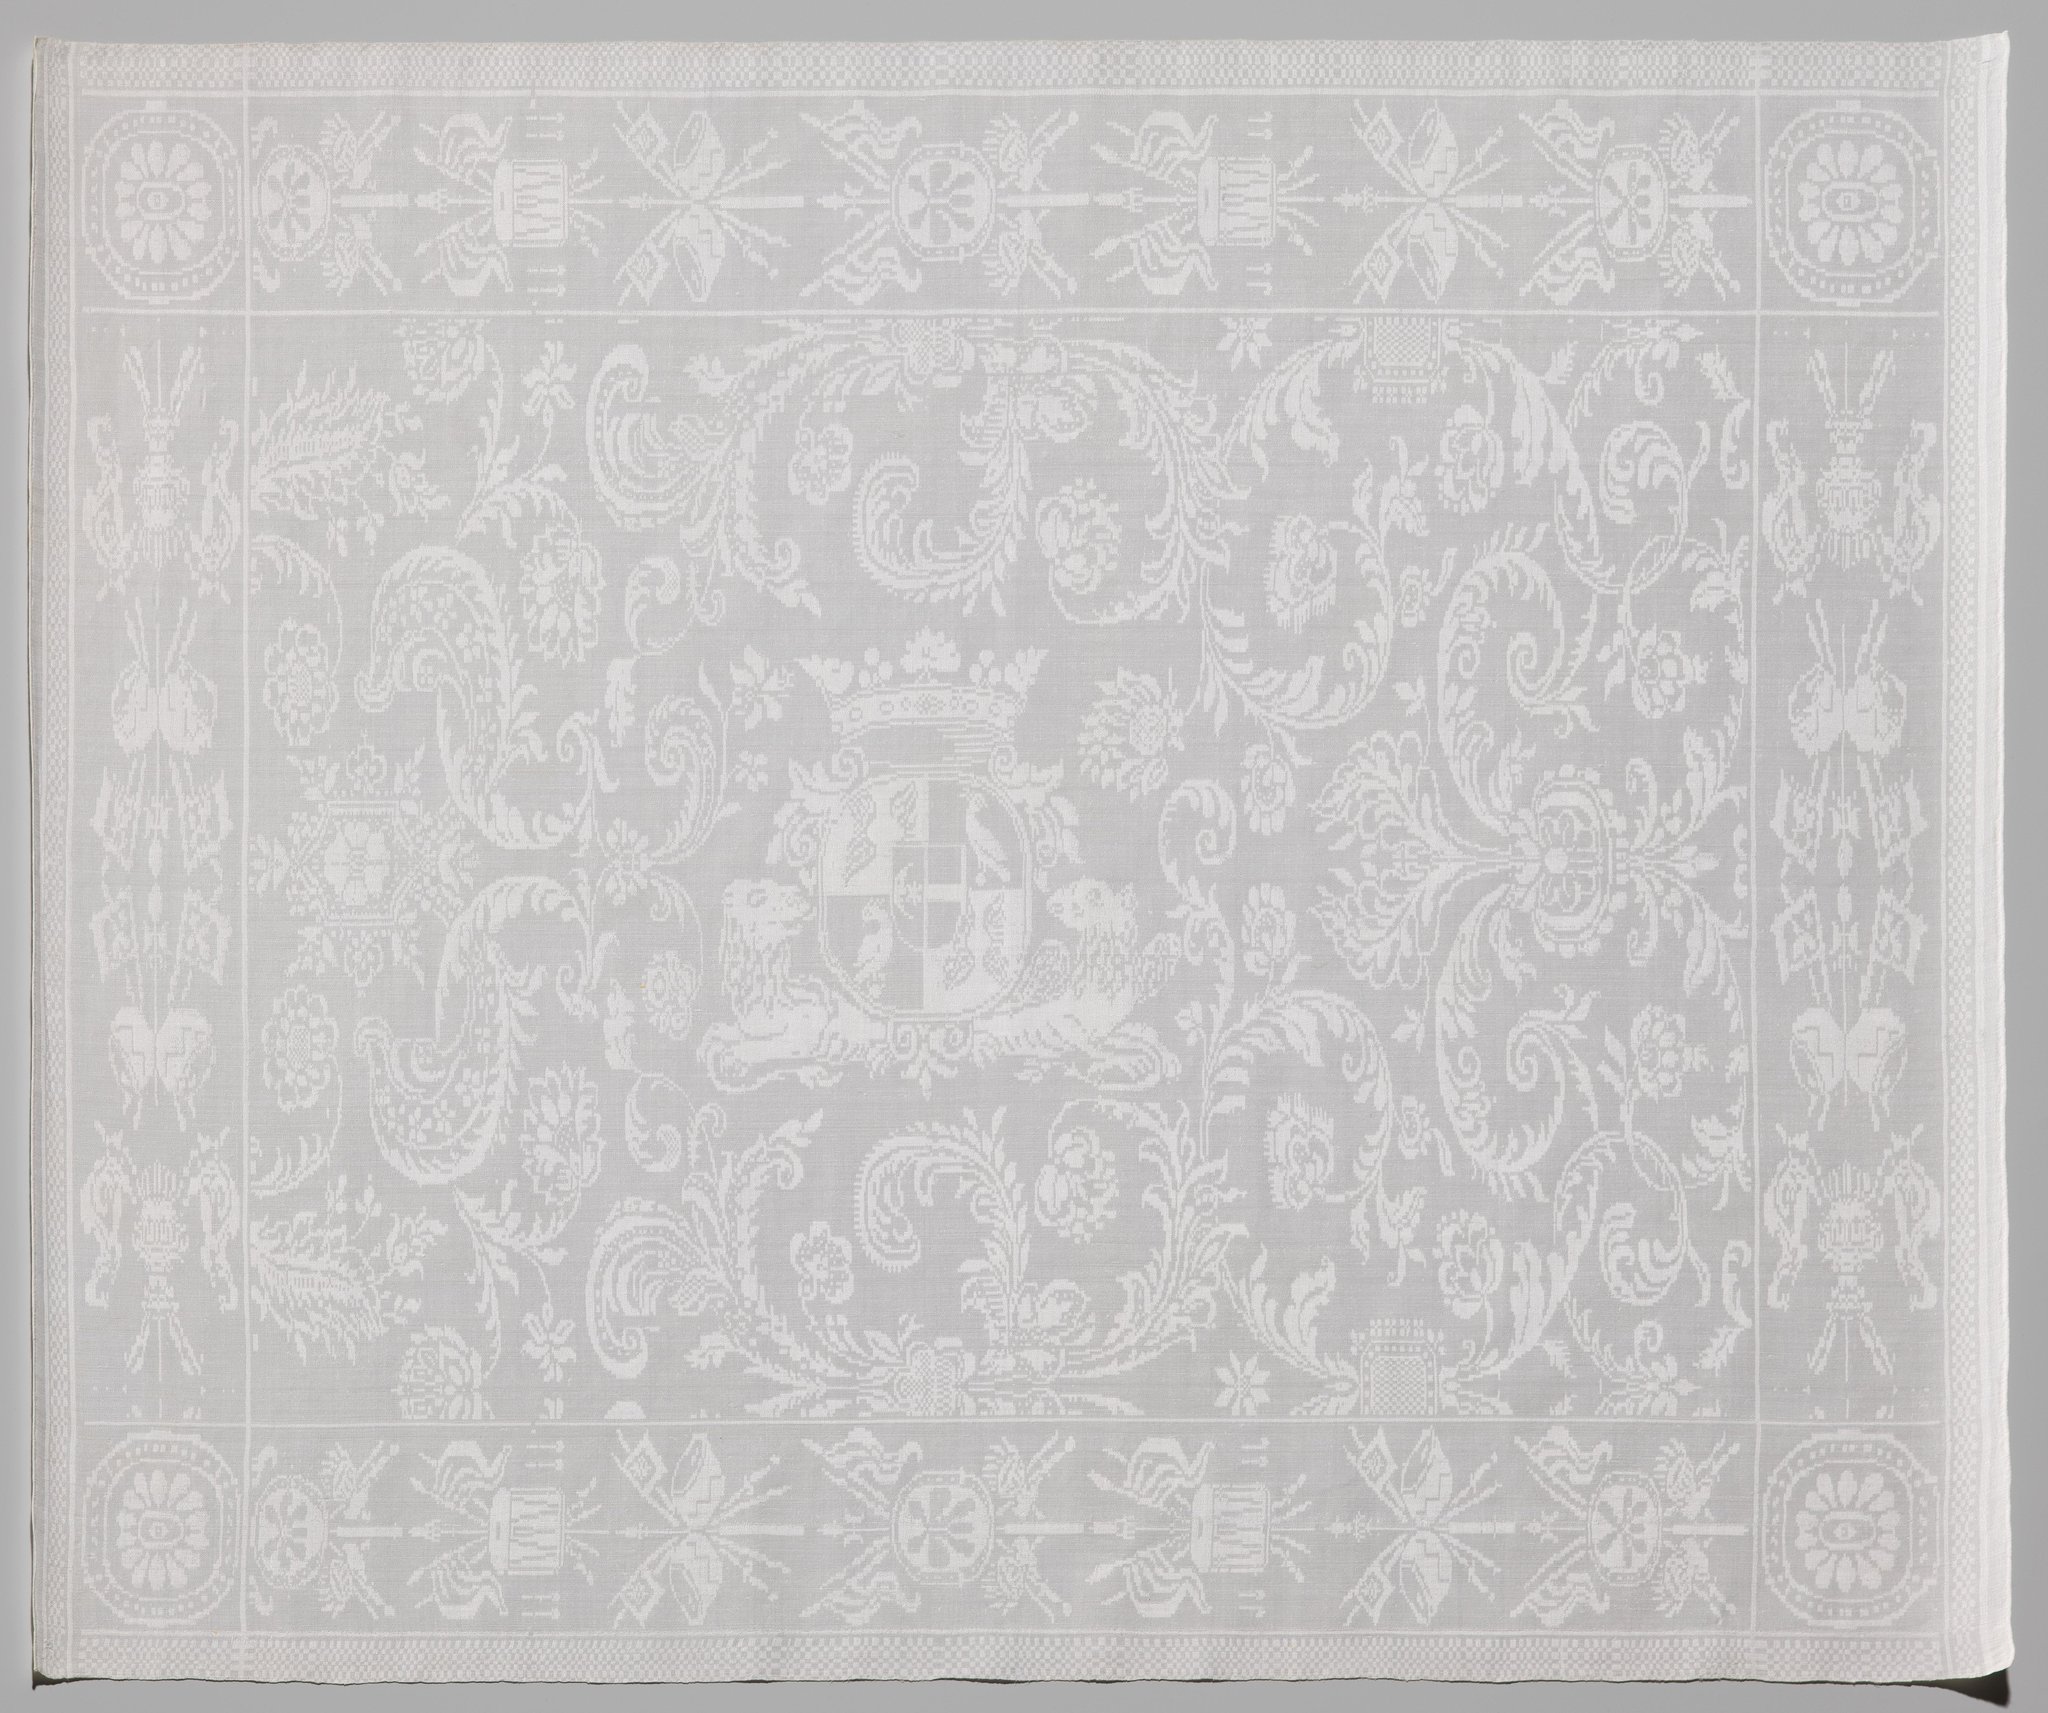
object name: napkin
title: Servet met het wapen van Cornelis Hop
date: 1700-1724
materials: linen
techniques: damask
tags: amsterdam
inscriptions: mark: ‘H’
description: Servet van linnendamast met het wapen van Cornelis Hop. Middenveld: symmetrische patroon van veelsoortige voluutranken met op de knooppunten geblokte verdikkingen. Daartussen een liggend ovaal schild met een wapen van Cornelis Hop (1685-1762), ambassadeur aan het hof van koning Lodewijk XV van Frankrijk: gevierendeeld, 1 en 4 kopvogel staande op bol (de vogel van 1 omgewend, die van 4 omziend); 2 en drie twee afgewende vleugels. Hartschild gedeeld: 1 een dwarsbalk, 2 rechts een vijfpuntige ster, links een gewende wassenaar. Het schild gedekt met vijfbladerige kroon. Schildhouders: rechts een afgewende adelaar, links een afgewende leeuw. Randen: wapentrofeeën. Hoeken: een rondas. Rondom blokkenrand.